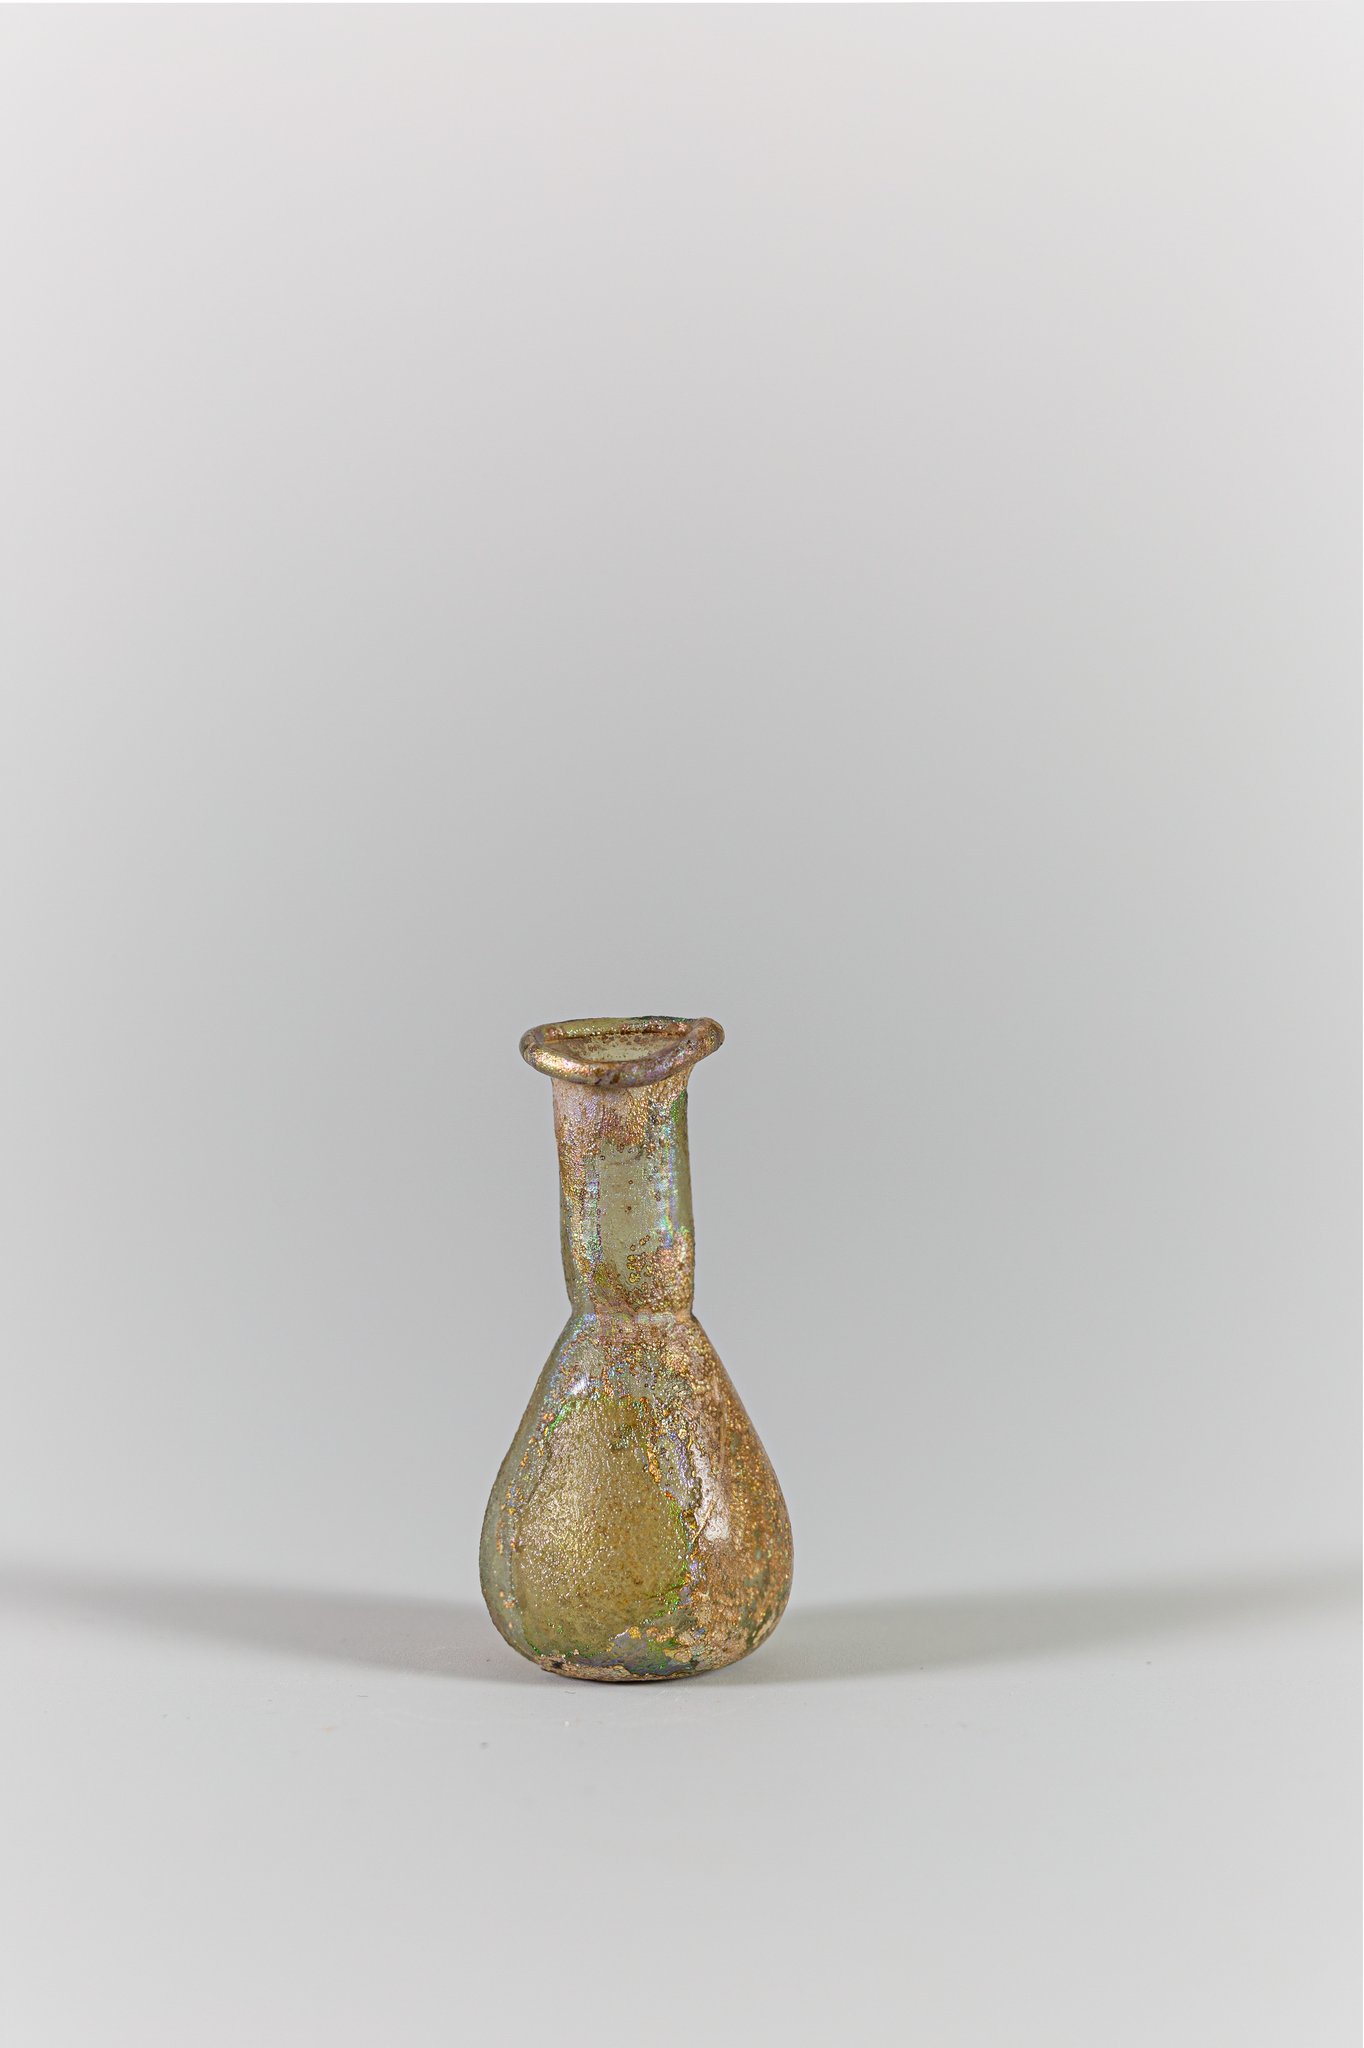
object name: perfume bottle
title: Glass perfume bottle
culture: roman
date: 1-100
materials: glass